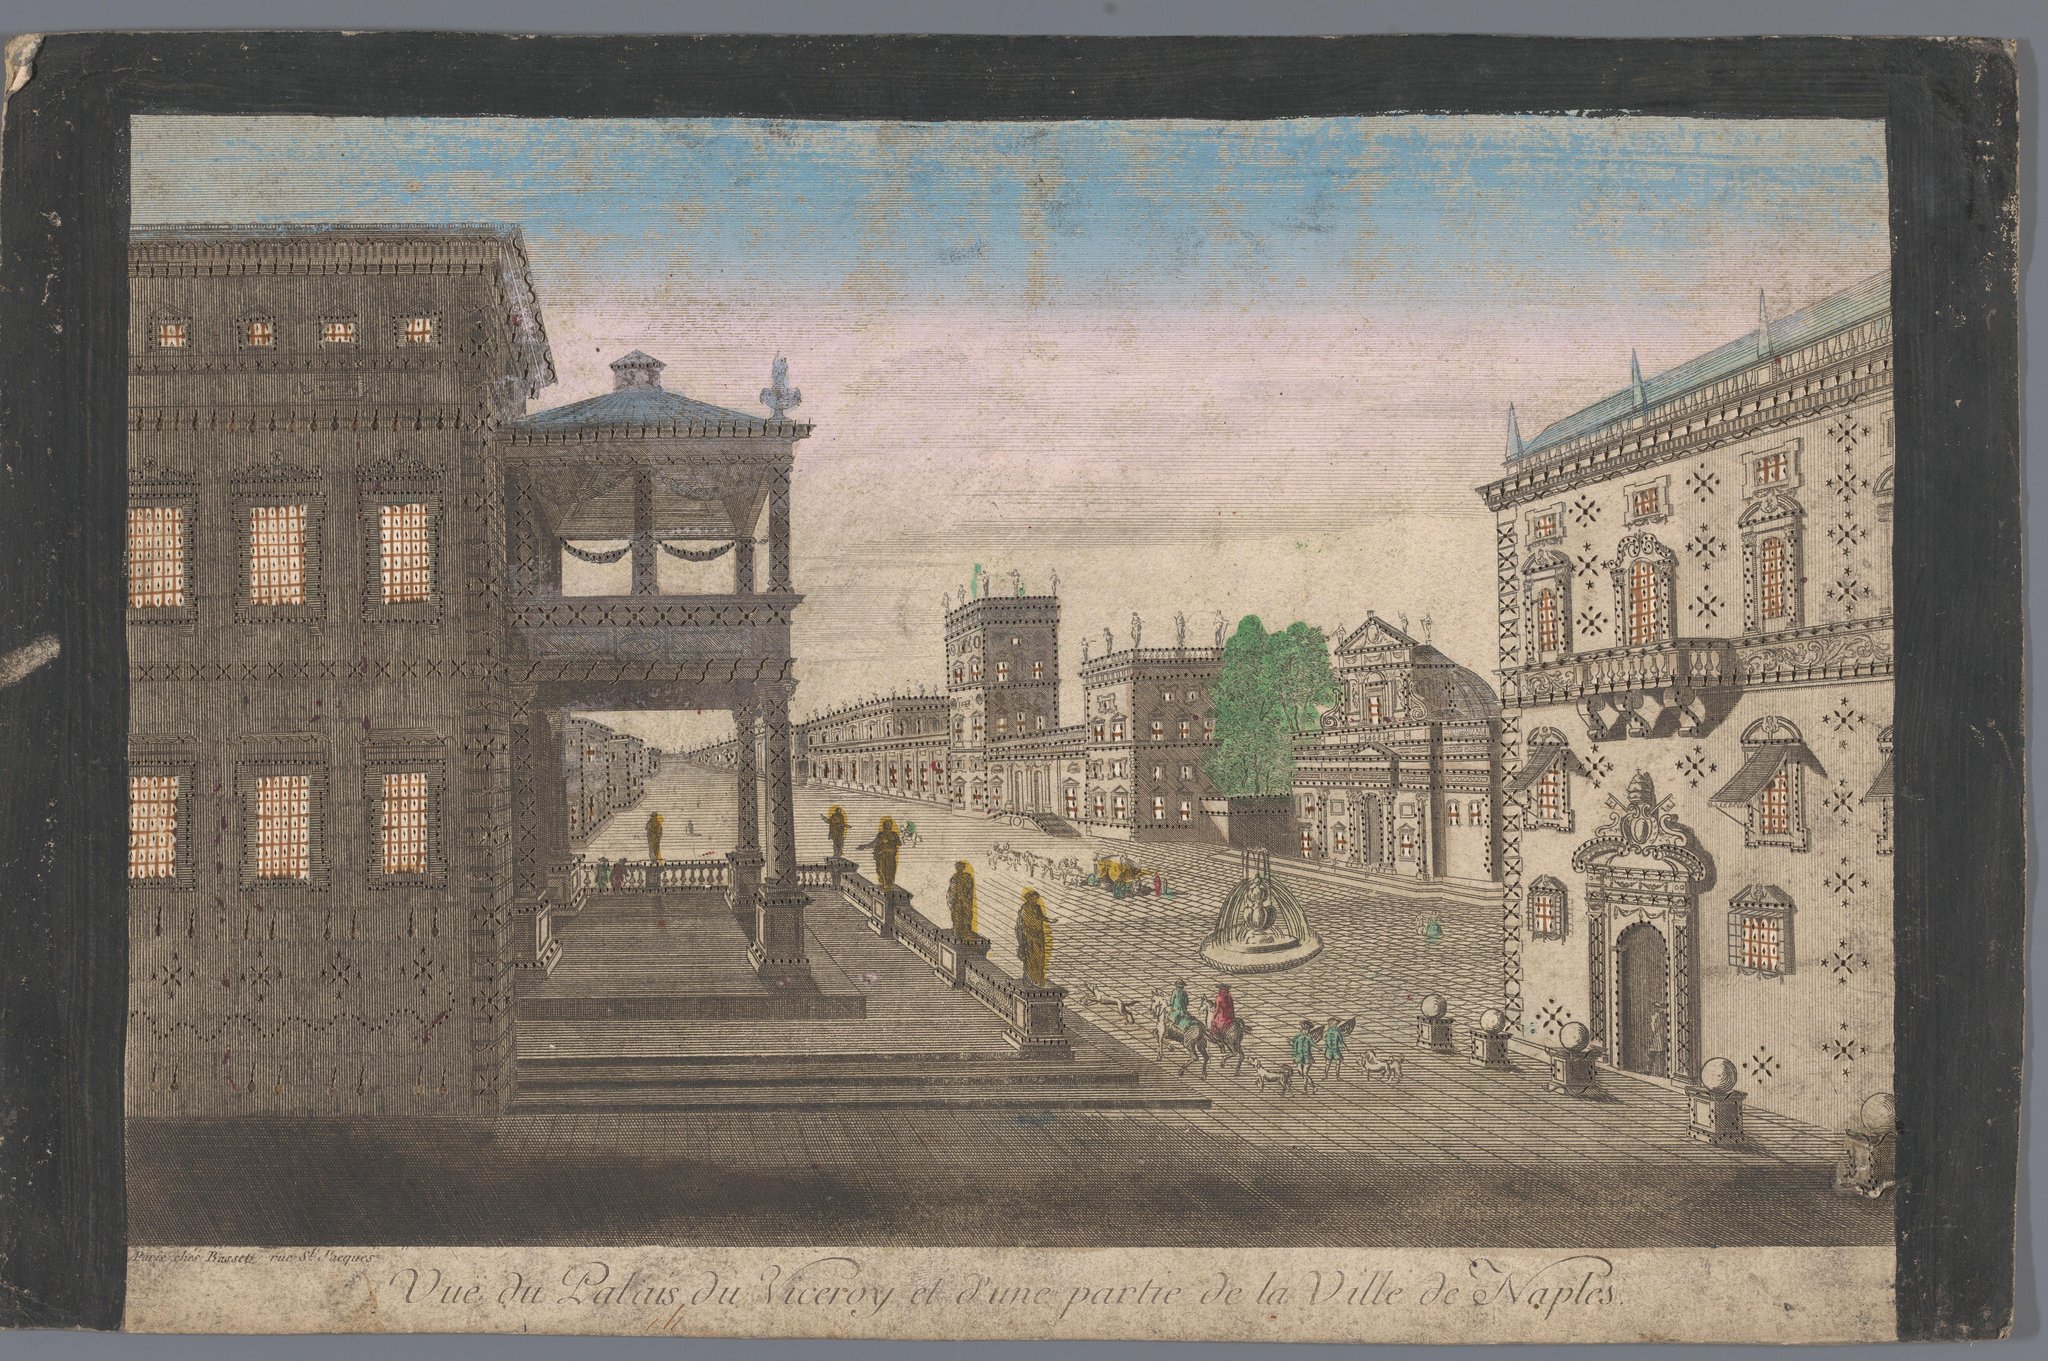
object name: print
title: Gezicht op het paleis van de onderkoning van Napels te Napels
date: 1700-1799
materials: cardboard, paint, paper, watercolor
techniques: brush, cutting, etching, perforating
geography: paris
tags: palace, street (+ city(-scape) with figures, staffage), naples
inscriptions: watermark